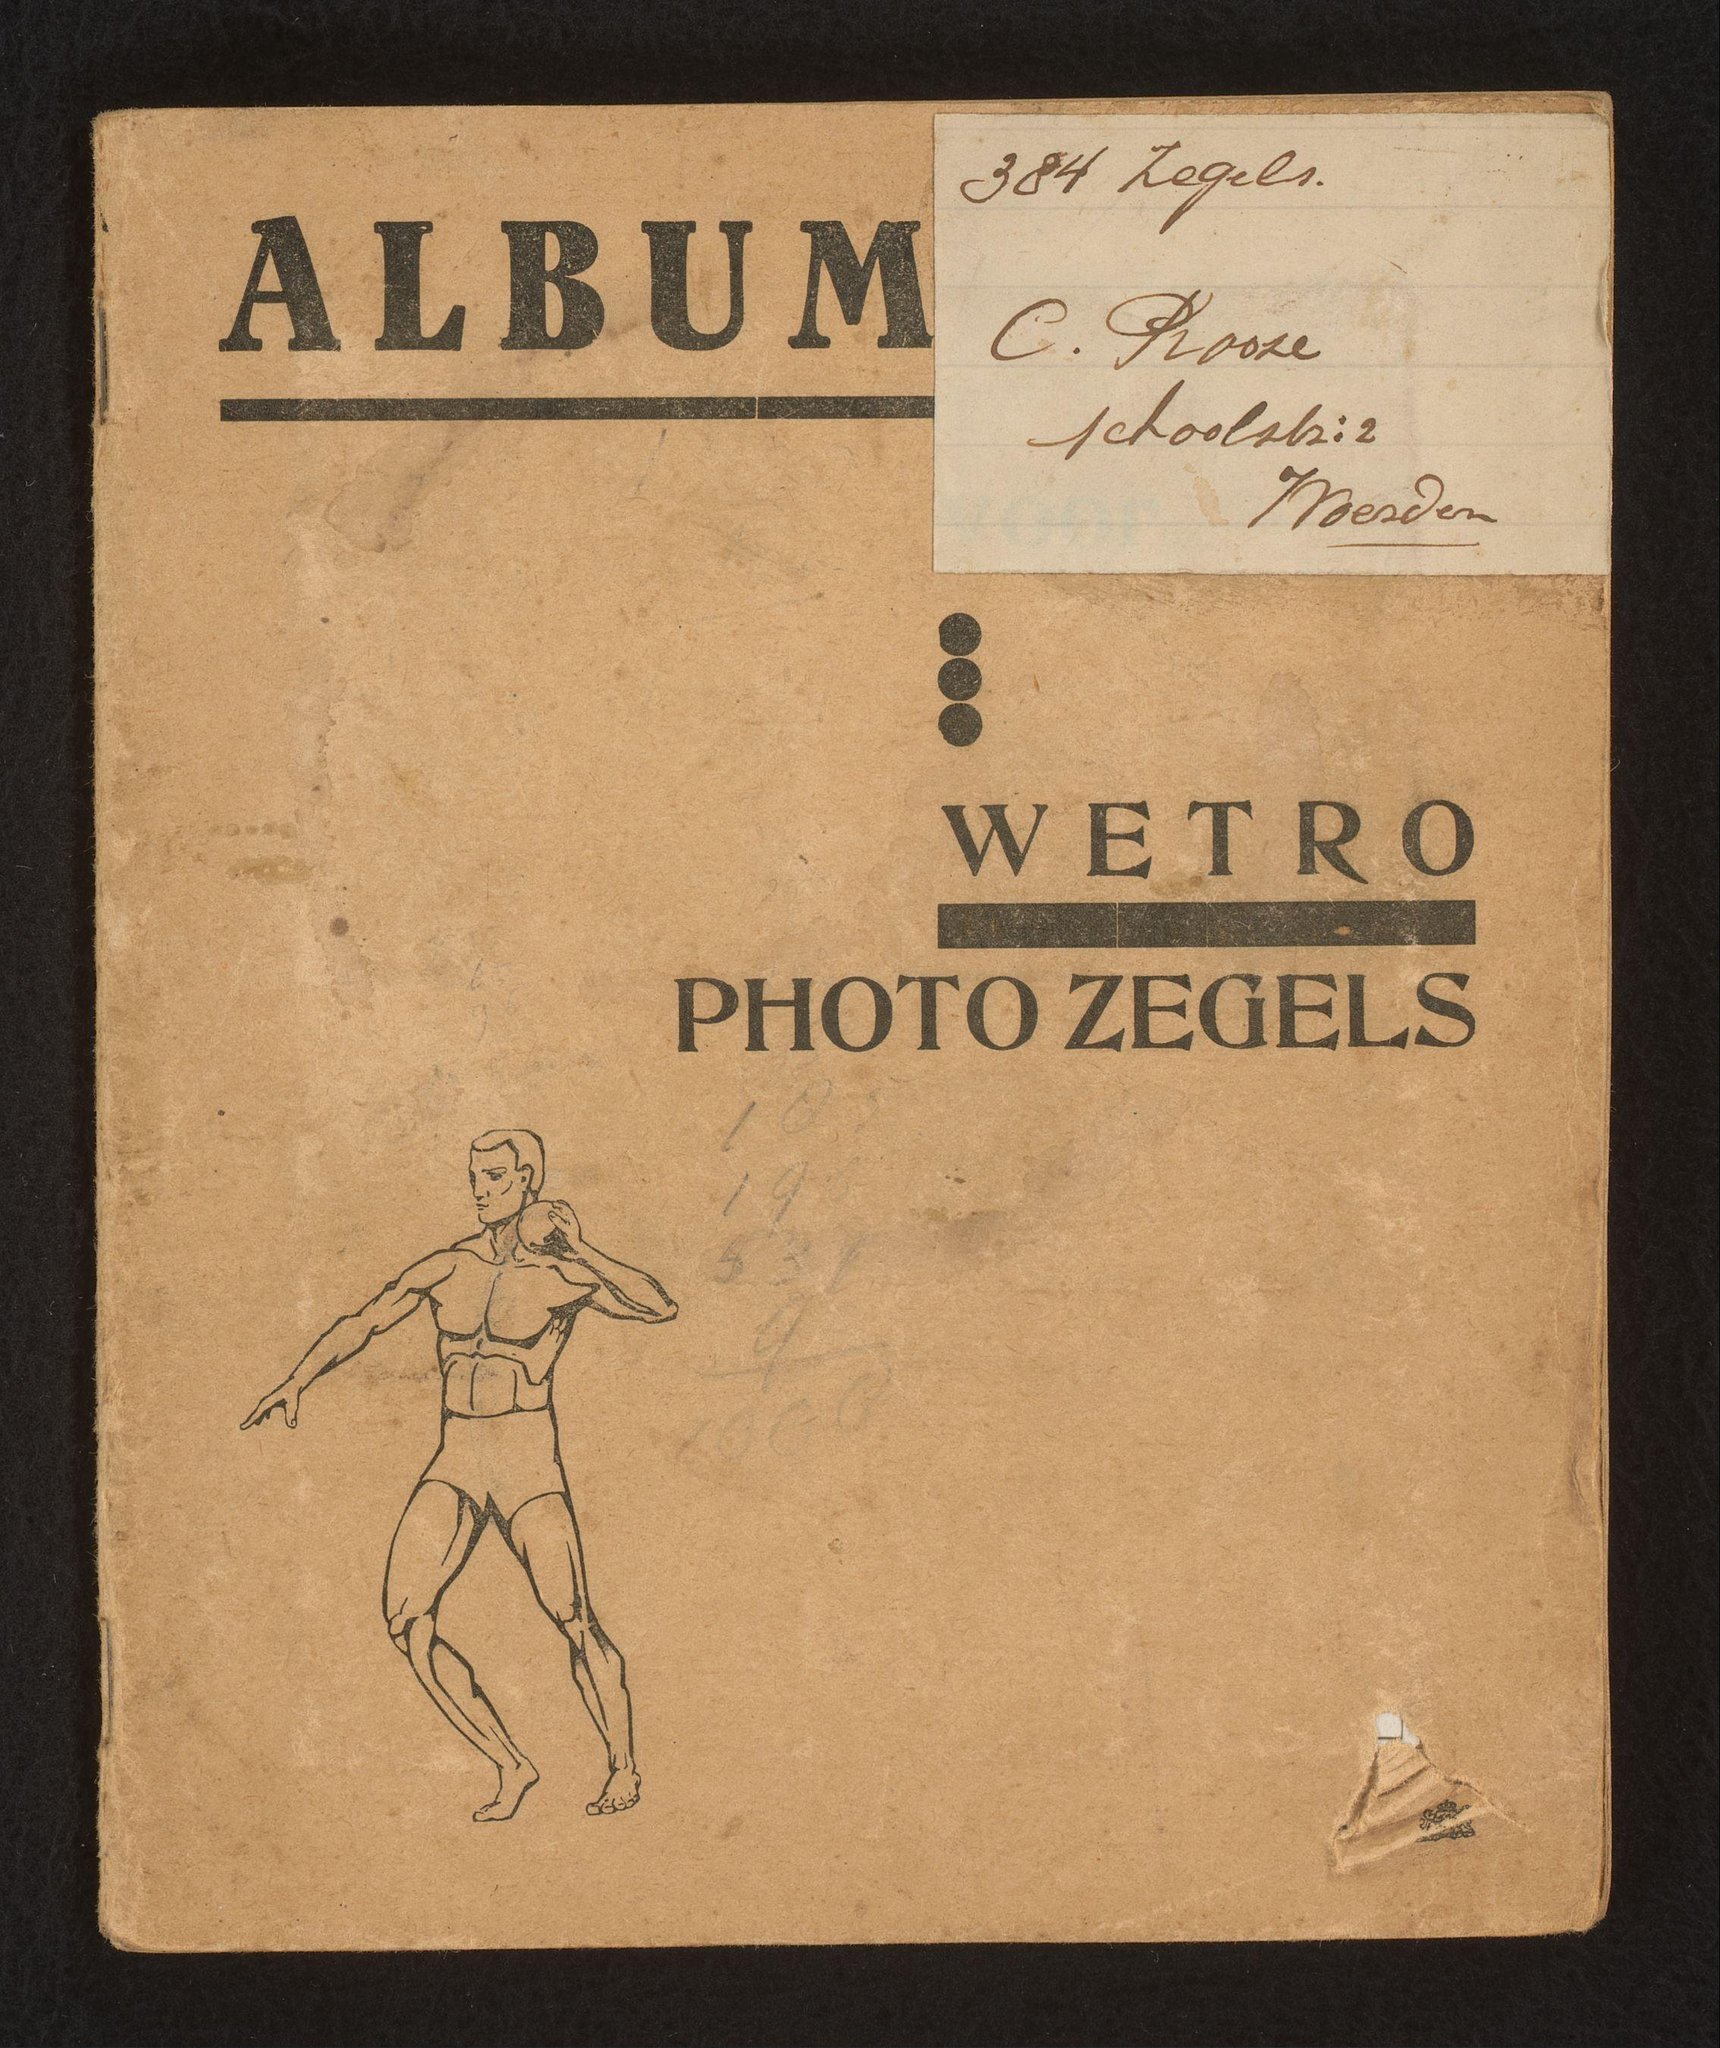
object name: photograph album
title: Album Wetro Photo zegels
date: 1937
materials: paper, photographic support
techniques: gelatin silver print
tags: rotterdam, amsterdam, bernhard (prins der nederlanden), juliana of the netherlands, swimming (sport) (+ sportsman, player, etc.), soccer, football (early names: soule, choule, cholle) (+ sportsman, player, etc.), historical persons, ruler, sovereign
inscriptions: annotation: ‘384 Zegels/ C. Rooze/ Schoolstr 2/ Woerden’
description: Plakboek met 384 fotozegels van onder andere Prinses Juliana en Prins Bernhard, ter gelegenheid van hun huwelijk op 7 januari 1937, en verschillende bekende sporters. De zegels werden verspreid bij de Utrechtse Courant.